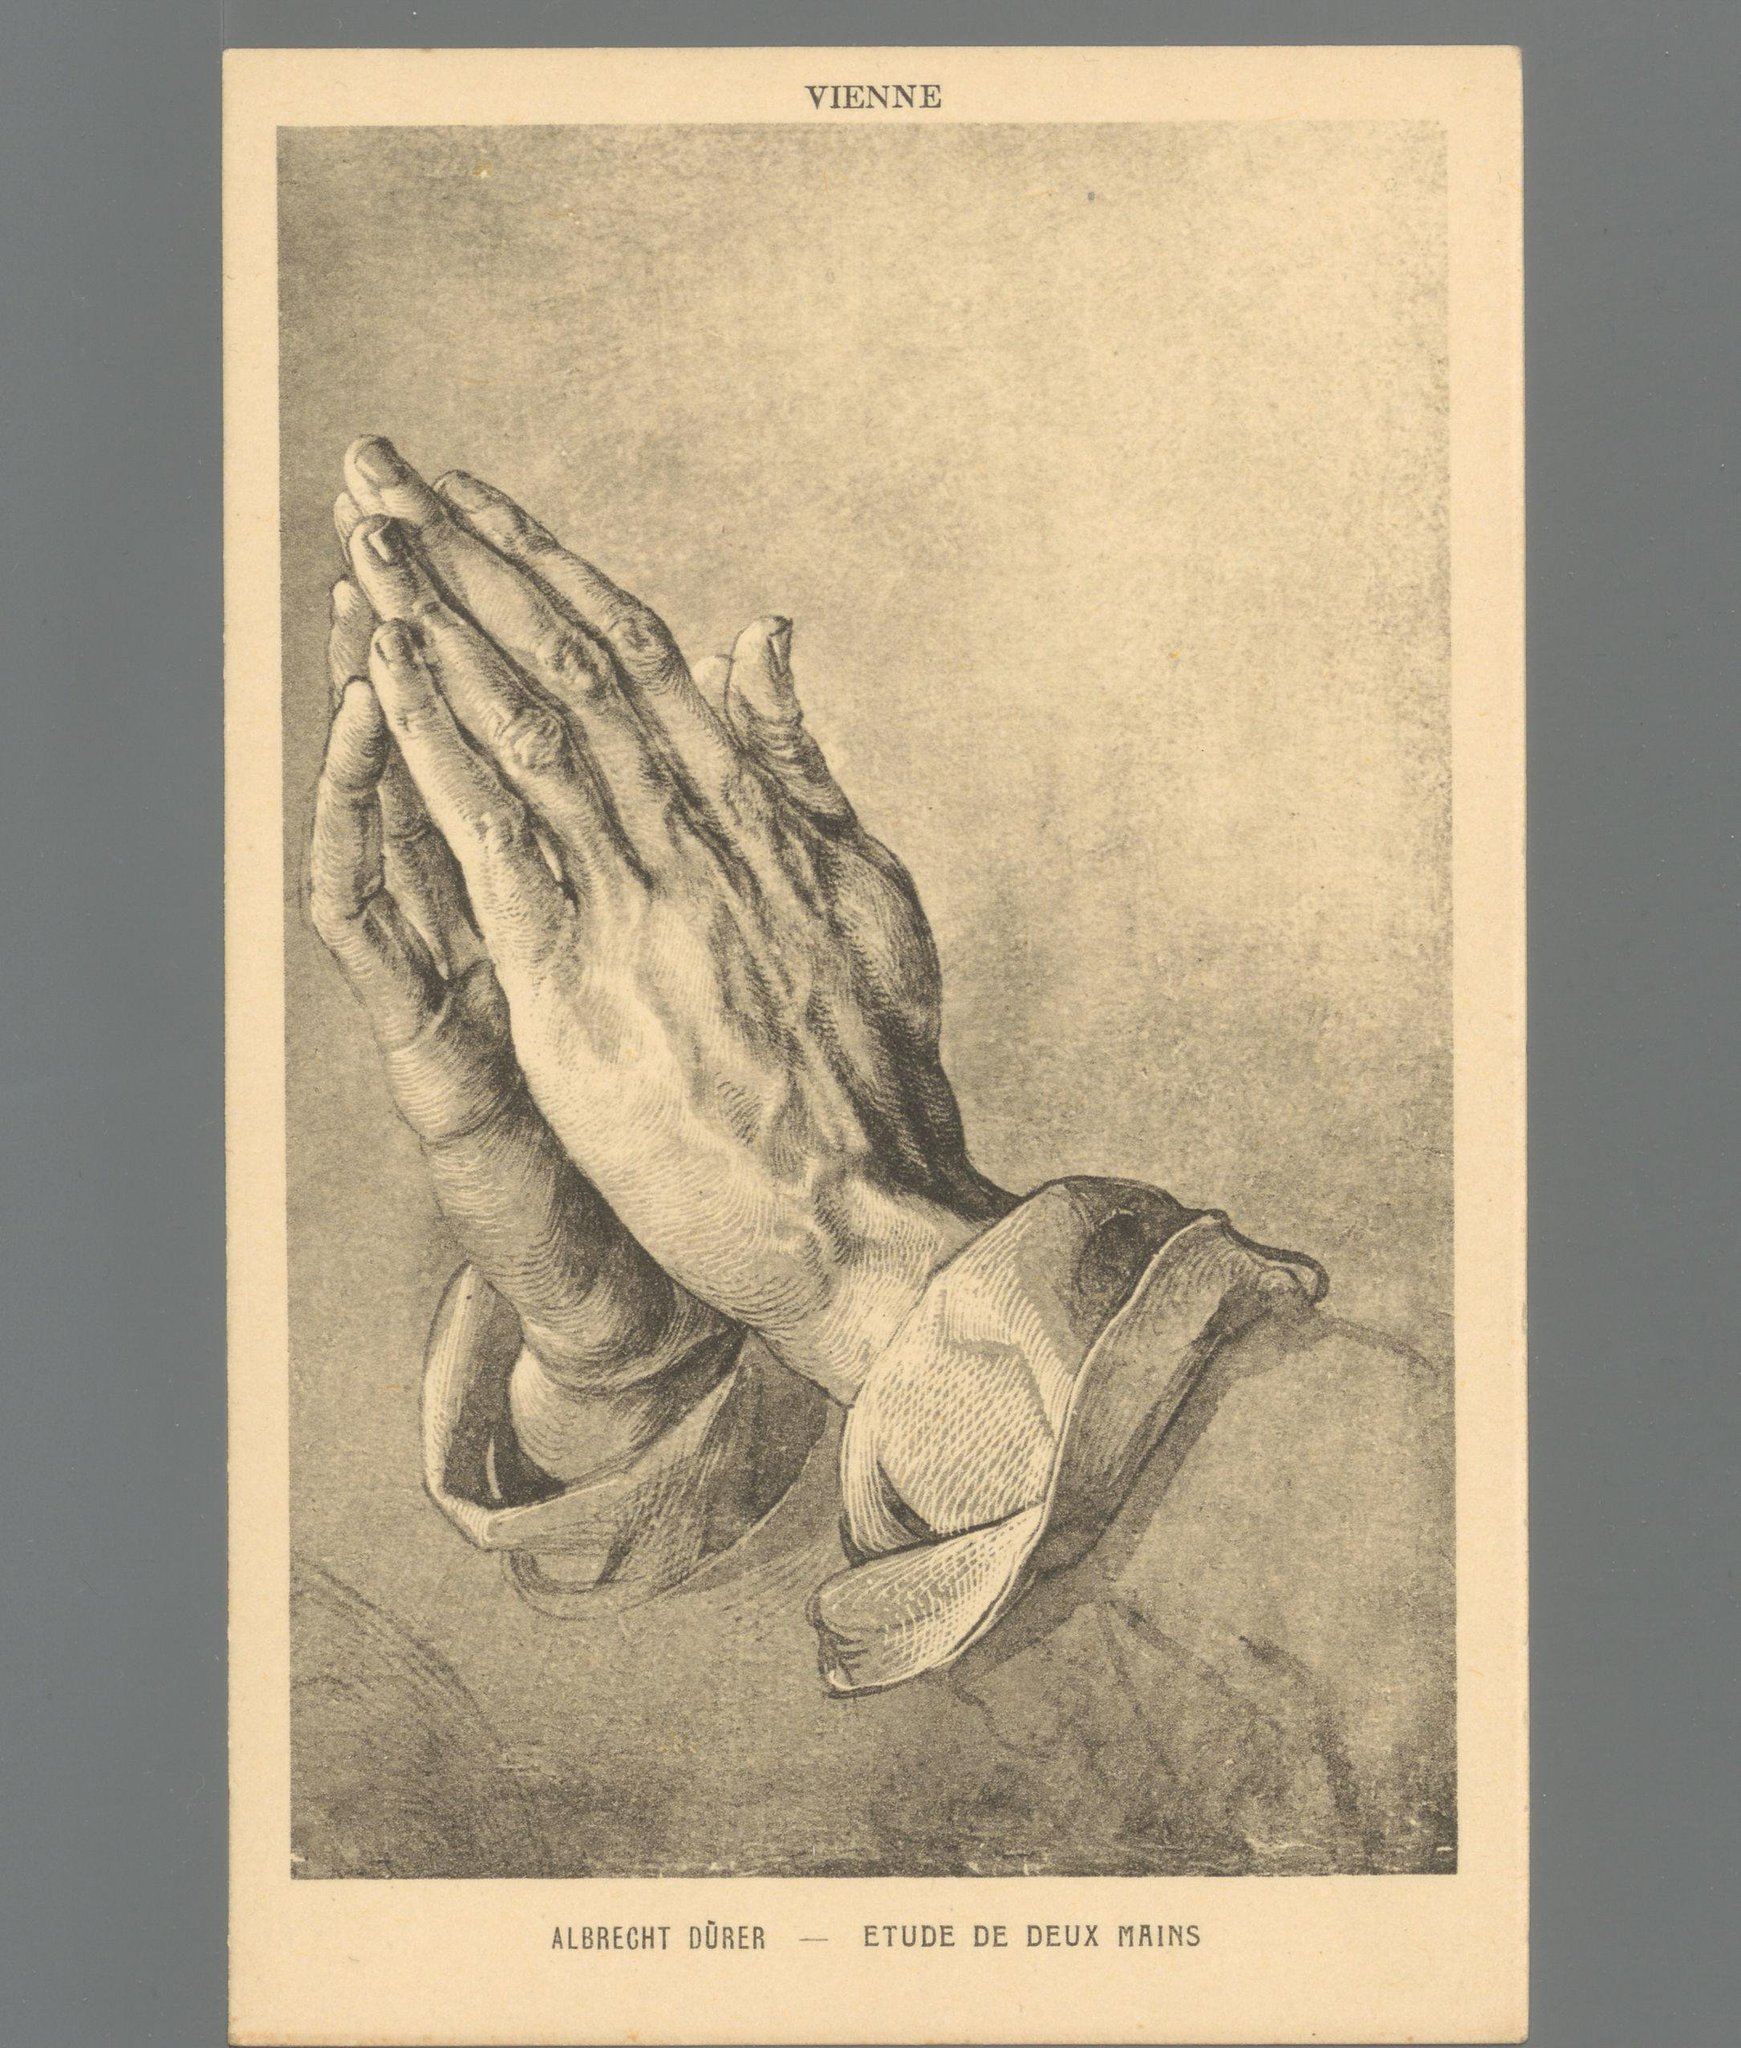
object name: photomechanical print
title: Vienne. Albrecht Dürer - Etude de deux mains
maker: Anonymous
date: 1903-1930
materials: cardboard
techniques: rotogravure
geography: paris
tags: picture, painting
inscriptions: collector's mark: ‘AFE v S’